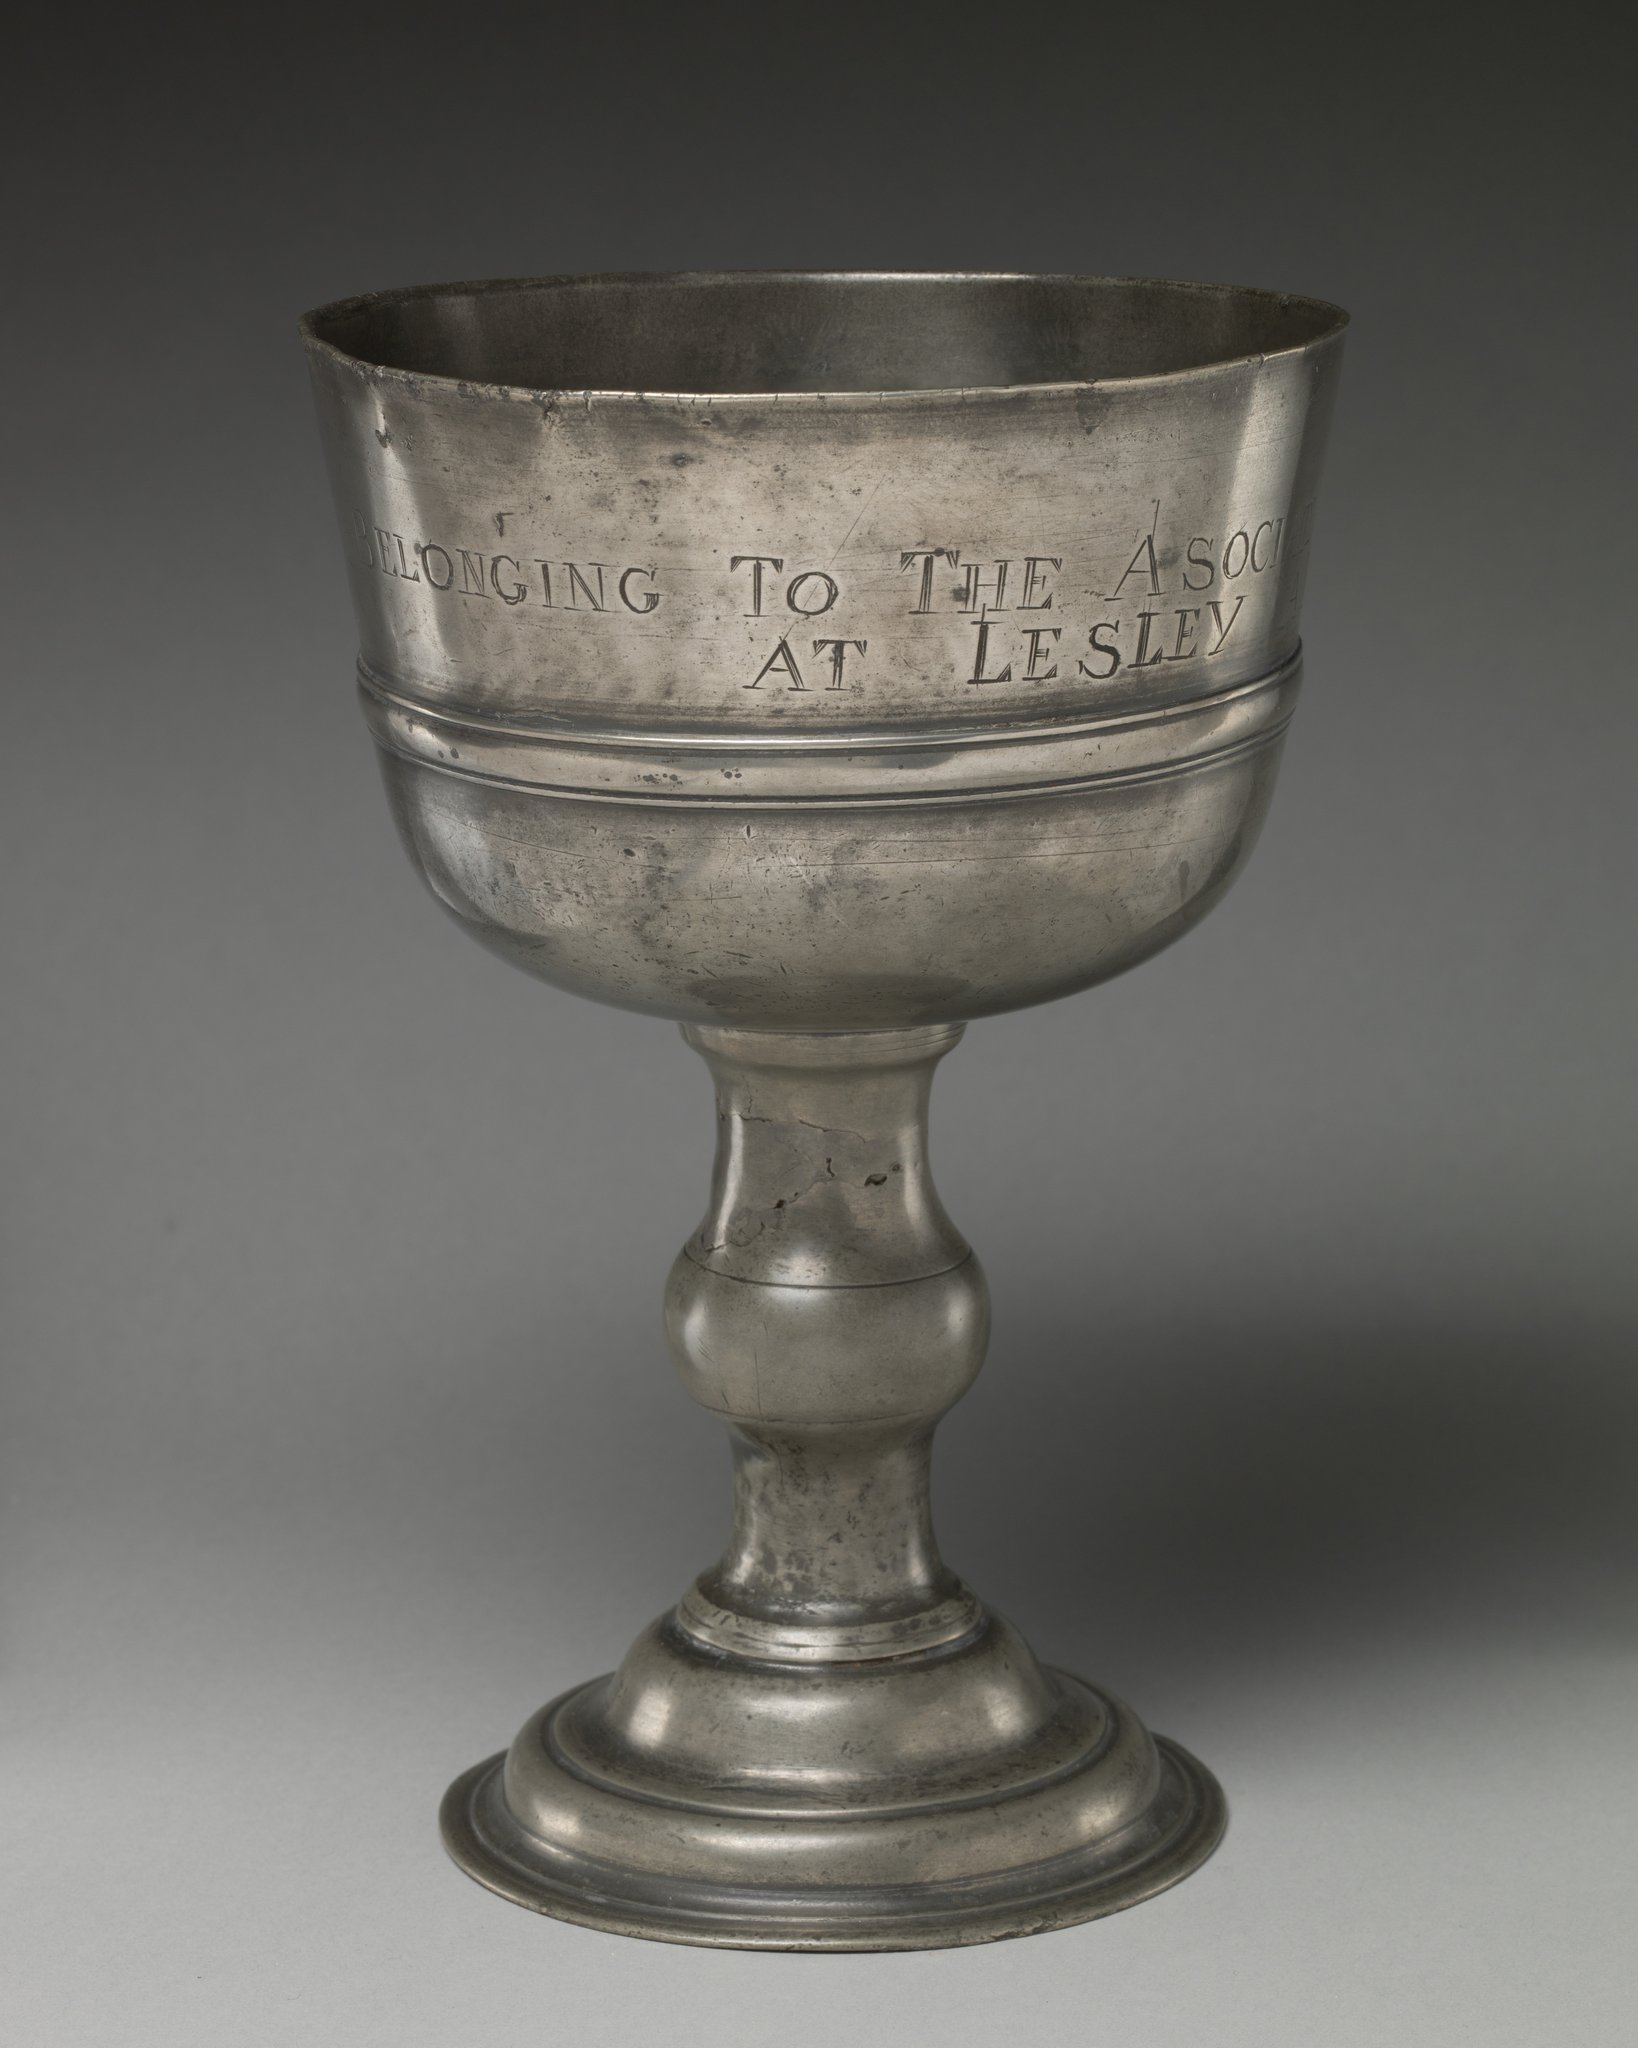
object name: chalice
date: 1762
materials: pewter